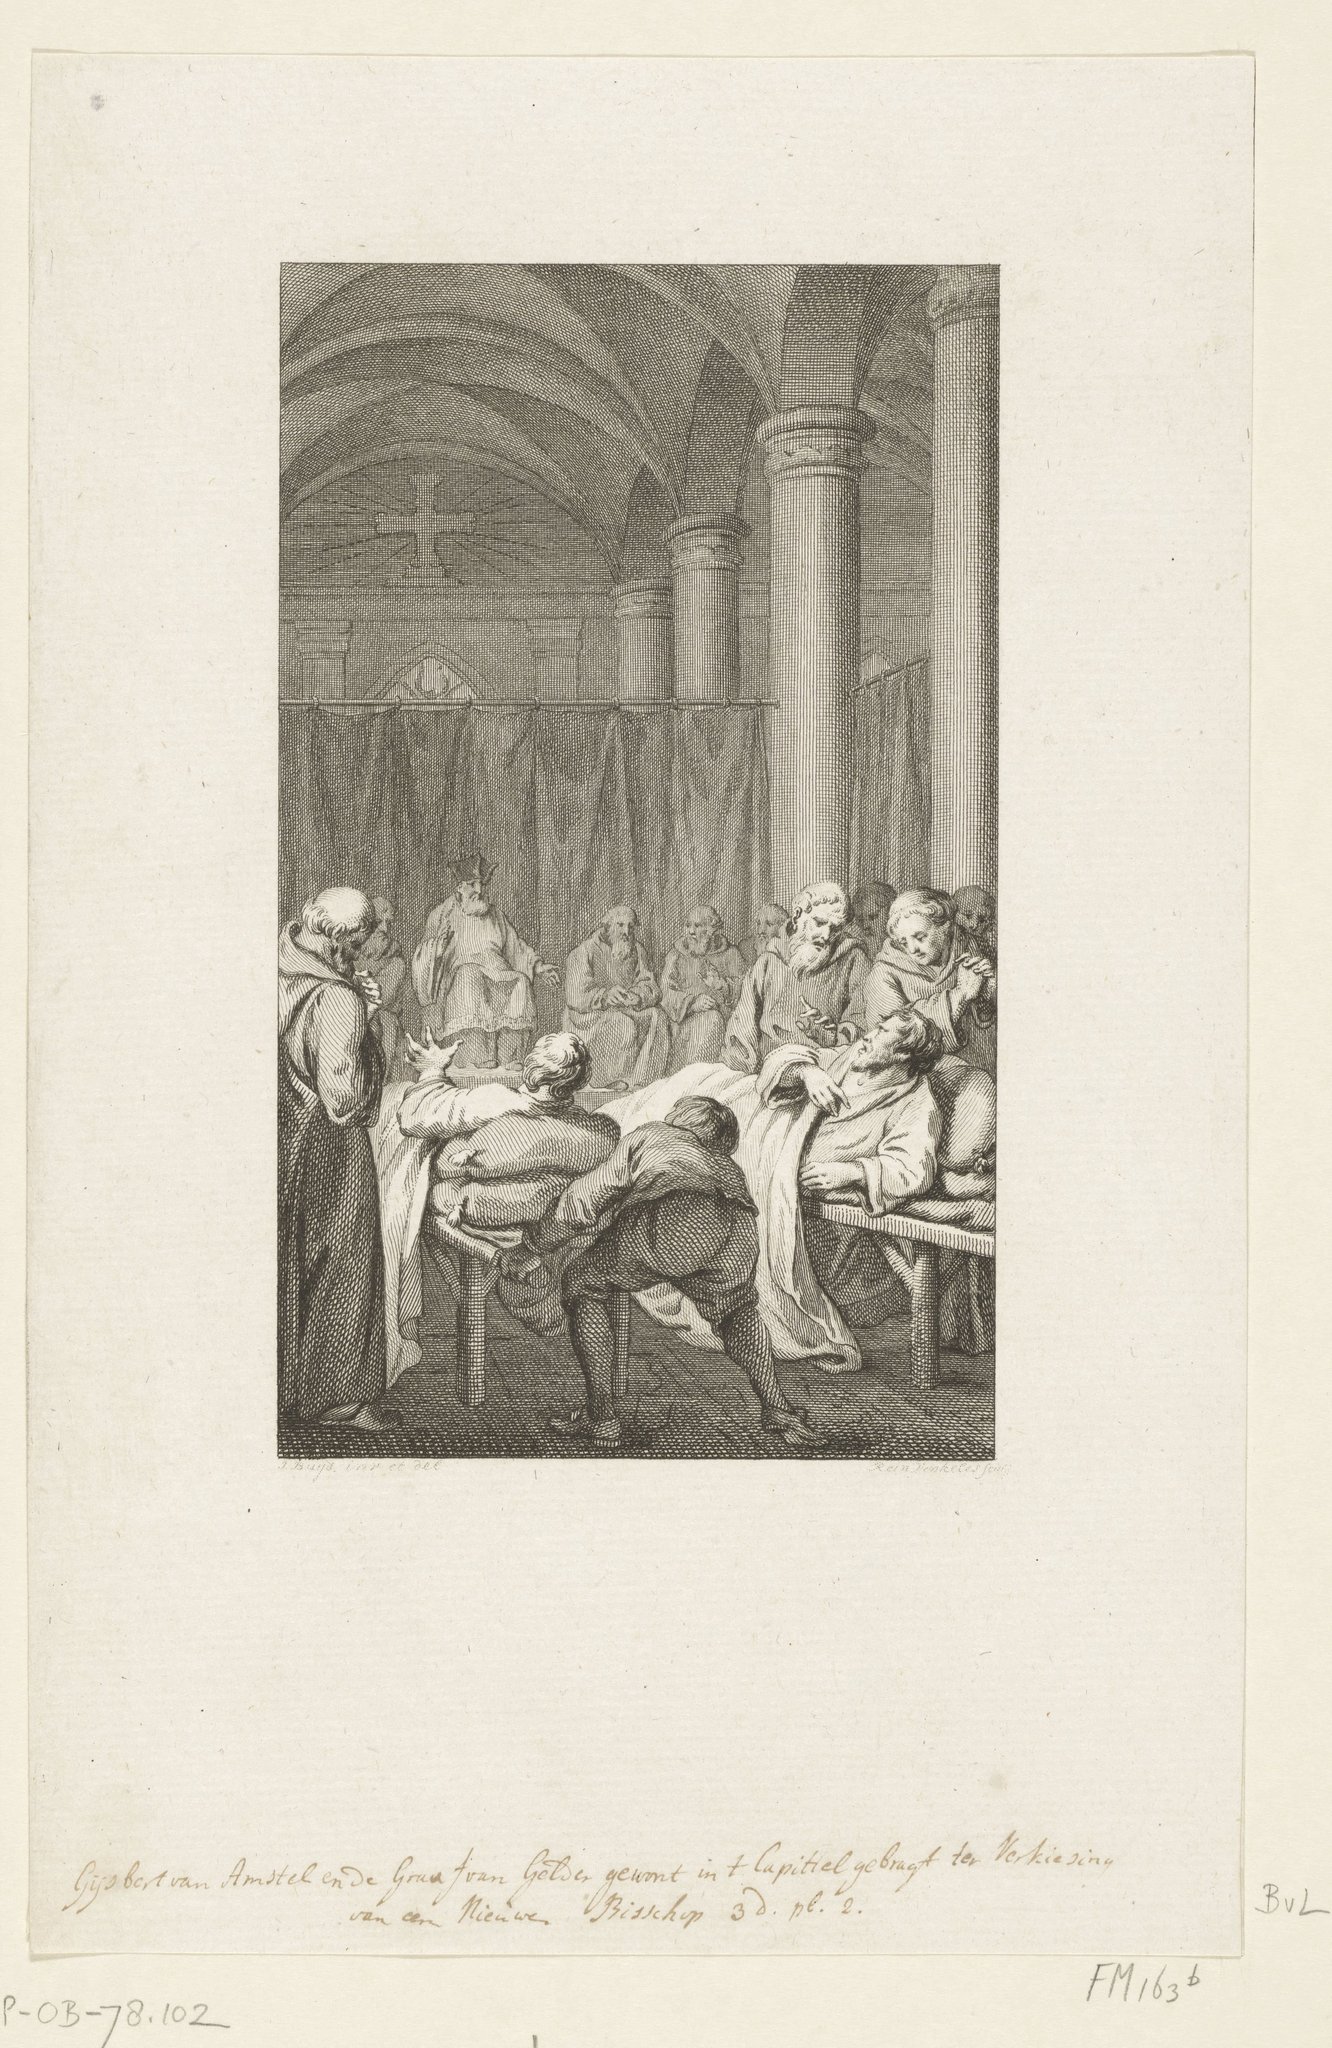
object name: print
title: Gijsbrecht II van Amstel en de graaf van Gelder gewond naar het kapittel gebracht bij de verkiezing van een nieuwe bisschop, 1227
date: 1786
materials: paper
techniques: etching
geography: netherlands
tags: archbishop, bishop, etc. (roman catholic), netherlands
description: Gijsbrecht II (of Gijsbert) van Amstel en de graaf van Gelder, gewond geraakt tijdens de Slag bij Ane op 27 juli 1227, worden liggend op brancards naar het kapittel gebracht om hun stem uit te brengen bij de verkiezing van een nieuwe bisschop als opvolger voor de bij de slag gedode bisschop Otto II.